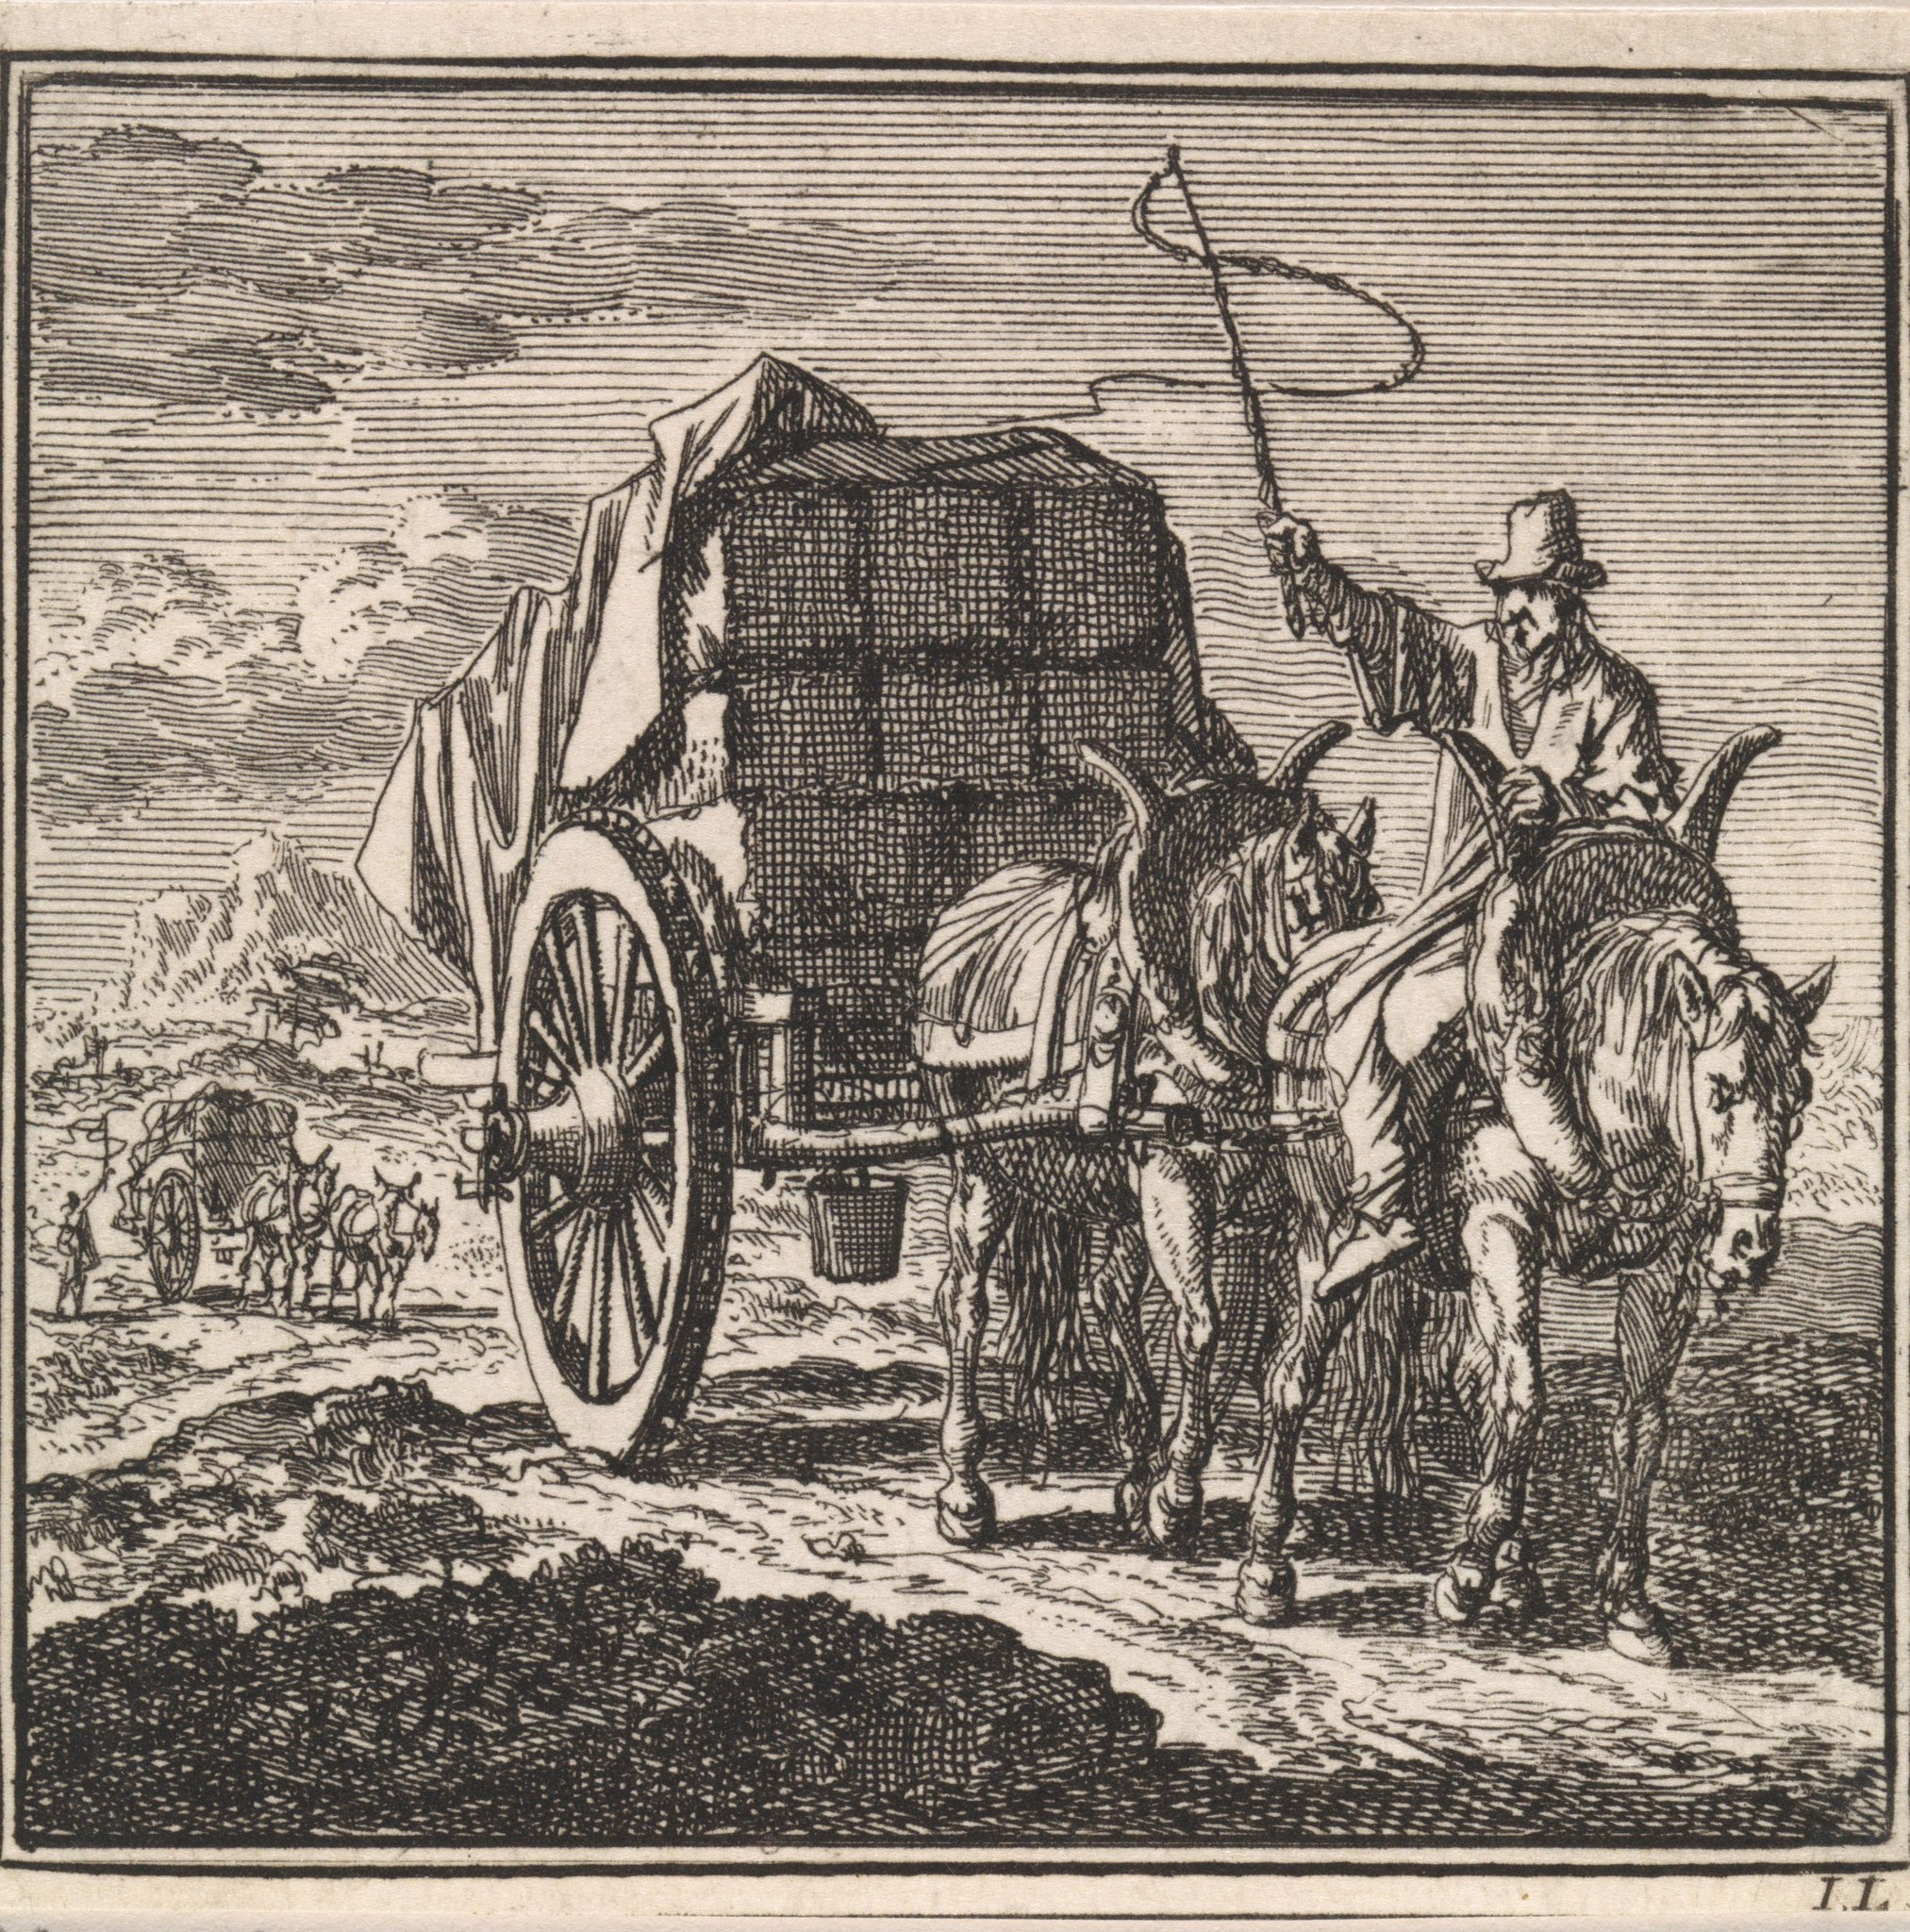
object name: print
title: Zwaar beladen kar getrokken door twee paarden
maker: jan luyken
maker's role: draughtsman, print maker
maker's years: 1649-1712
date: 1711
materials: paper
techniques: etching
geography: amsterdam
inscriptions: collector's mark: Lugt 2228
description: Illustratie voor: Luyken, Jan. De Bykorf des Gemoeds. Amsterdam: Pieter Arentsz. II (wed.) en Cornelis van der Sys, 1711, p. 202.